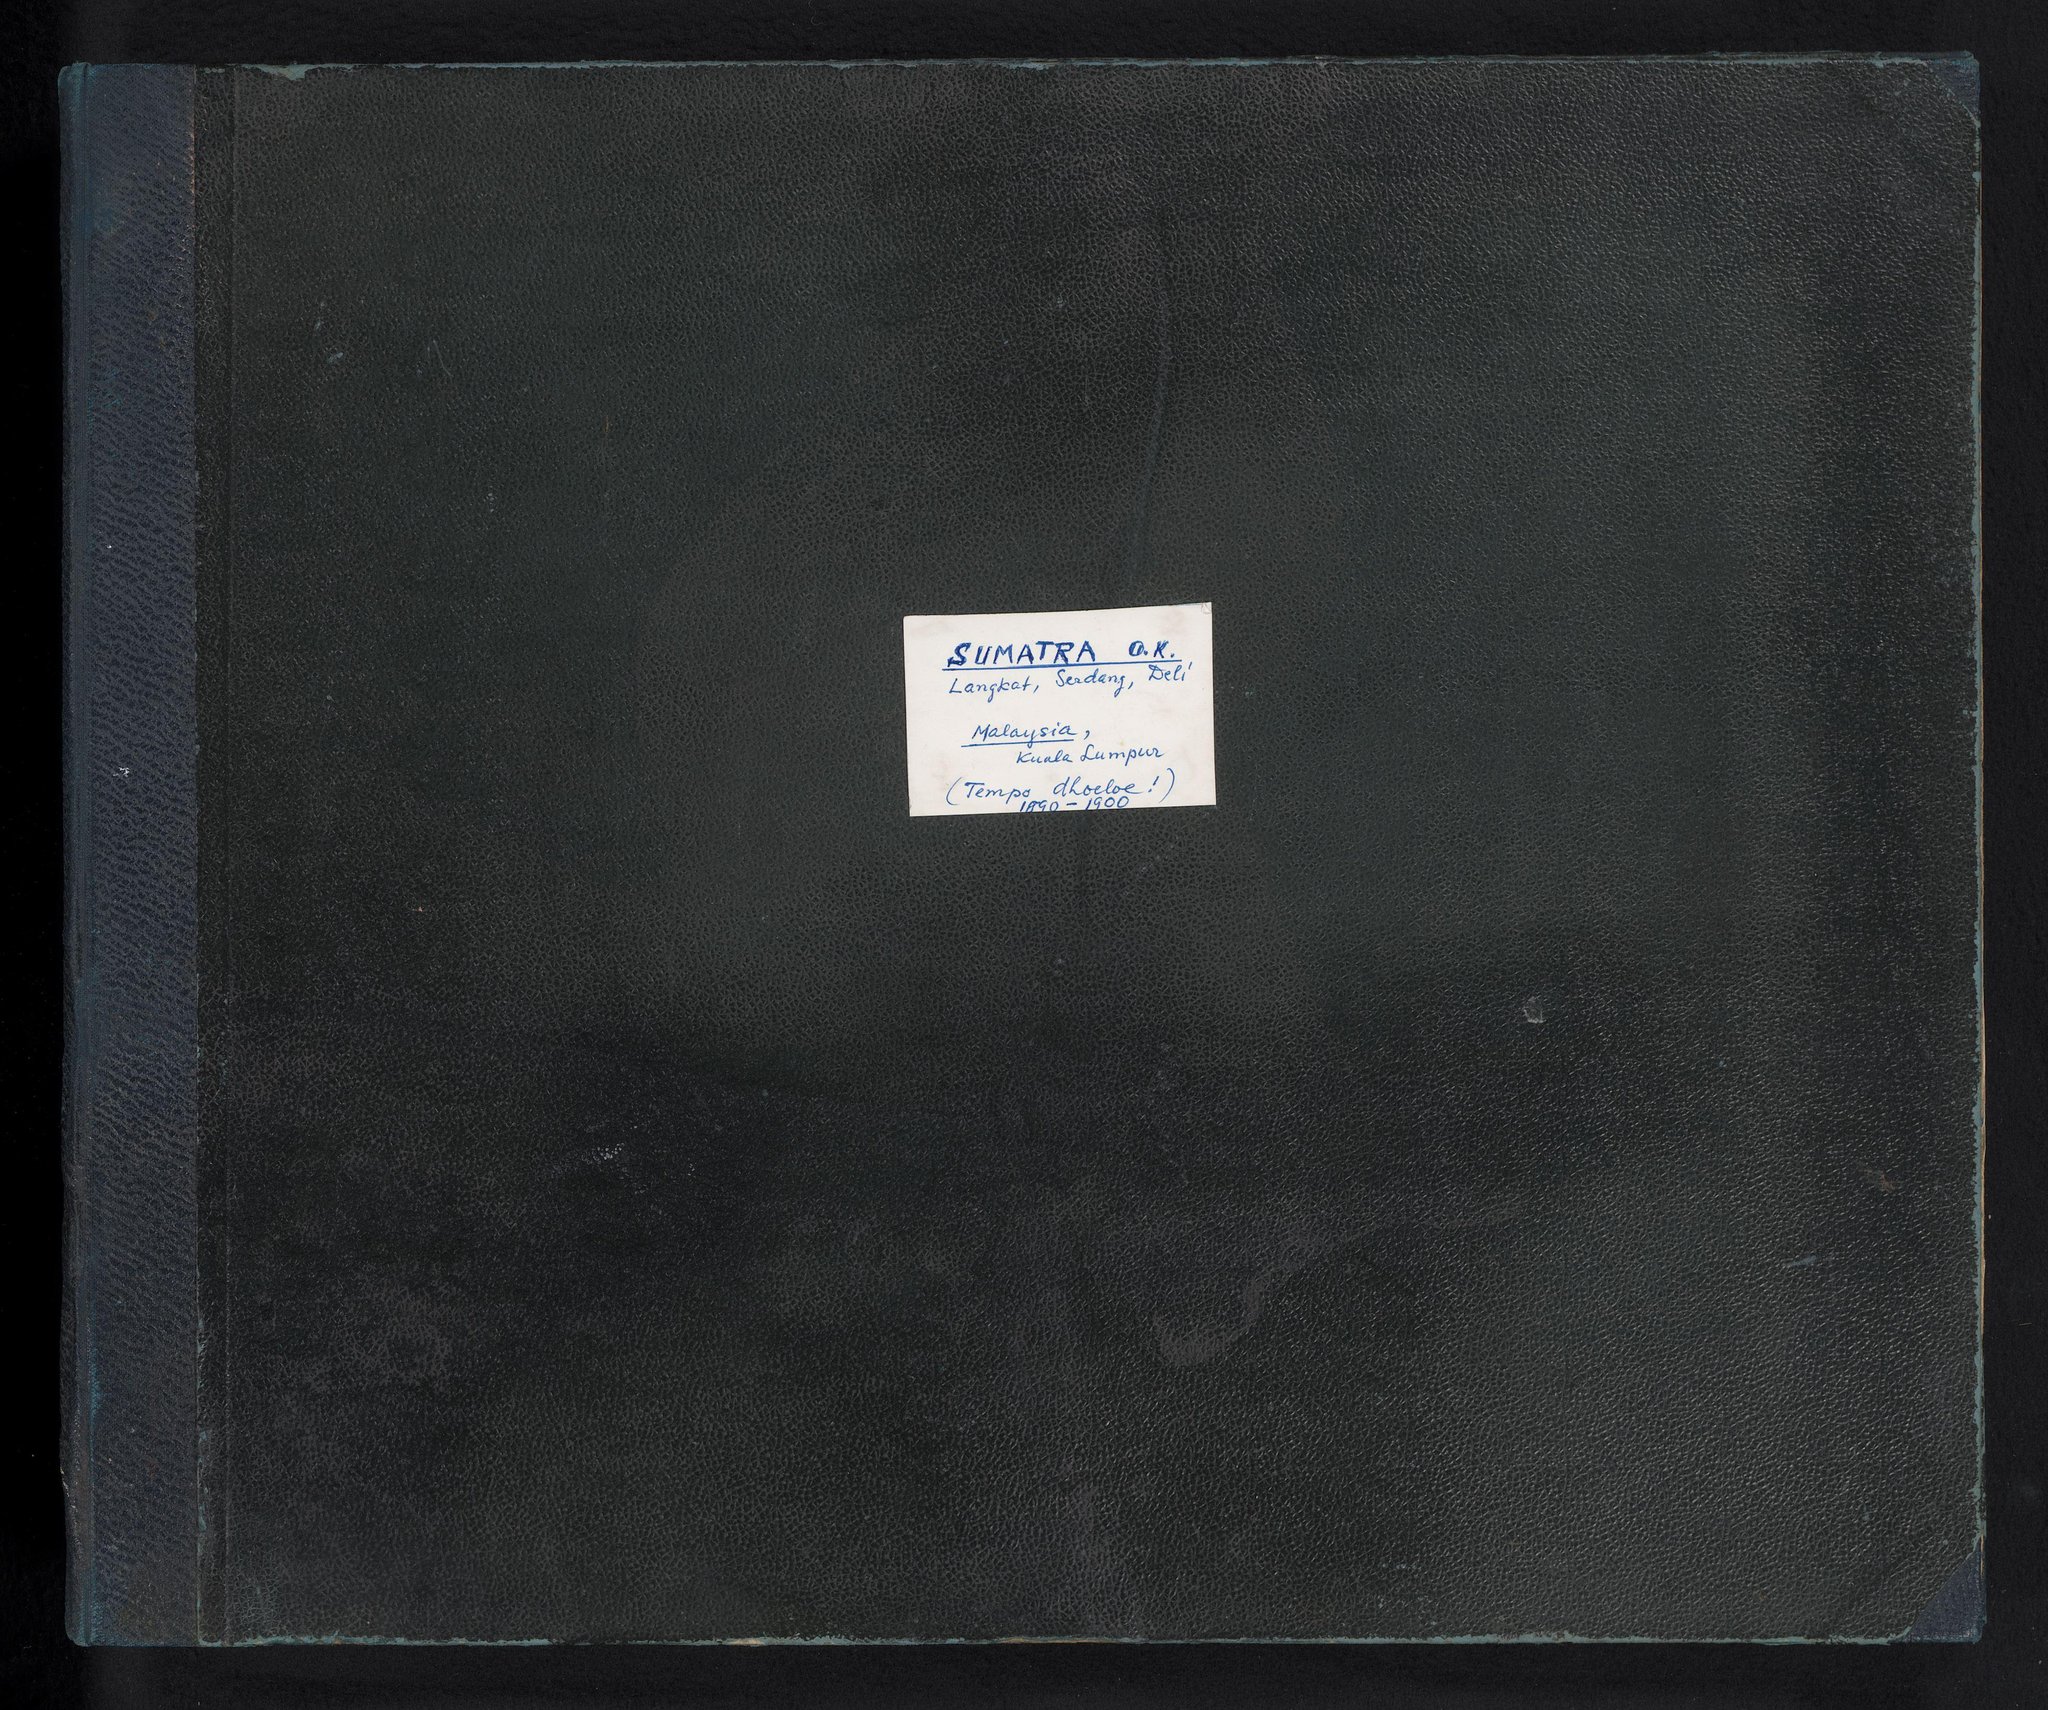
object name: scrapbook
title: Fotoalbum met 23 foto's van Sumatra en Egypte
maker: Anonymous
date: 1890-1900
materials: cardboard, leather, paper, photographic support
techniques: albumen print, decorated paper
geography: sumatra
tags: plantation, historical persons - bb - woman, historical persons, working class, labourers, tobacco, prospect of city, town panorama, silhouette of city, sumatra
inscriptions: inscription: ‘O. SANDEL/ v. Beethovensingel 100/ ROTTERDAM - Hilligersberg/ Telefoon (0 10) 18 97 35 x/ Giro 18 19 16/ x 22 21 30’, annotation: ‘SUMATRA O.K./ Langkat, Serdang, Deli/ Malaysia,/ Kuala Lumpur/ (Tempo Dhoeloe!)/ 1890 - 1900’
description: Fotoalbum met in totaal 23 foto's op 18 pagina's. Afgebeeld zijn planters, bedienden en contractarbeiders op plantages op Sumatra. Daarnaast bevat het album drie gezichten op Caïro, Suez en Port Said en portretten van Egyptenaren. Elf foto's zijn gemaakt op Sumatra door een anonieme fotograaf. Twaalf foto's zijn gemaakt in Turkije en Egypte, waarvan vier foto's in Egypte door C. & G. Zangaki. Op de buitenzijde van het voorplat is een opschrift geplakt, waarin staat: "SUMATRA O.K./ Langkat, Serdang, Deli/ Malaysia,/ Kuala Lumpur/ (Tempo Dhoeloe!)/ 1890 - 1900".